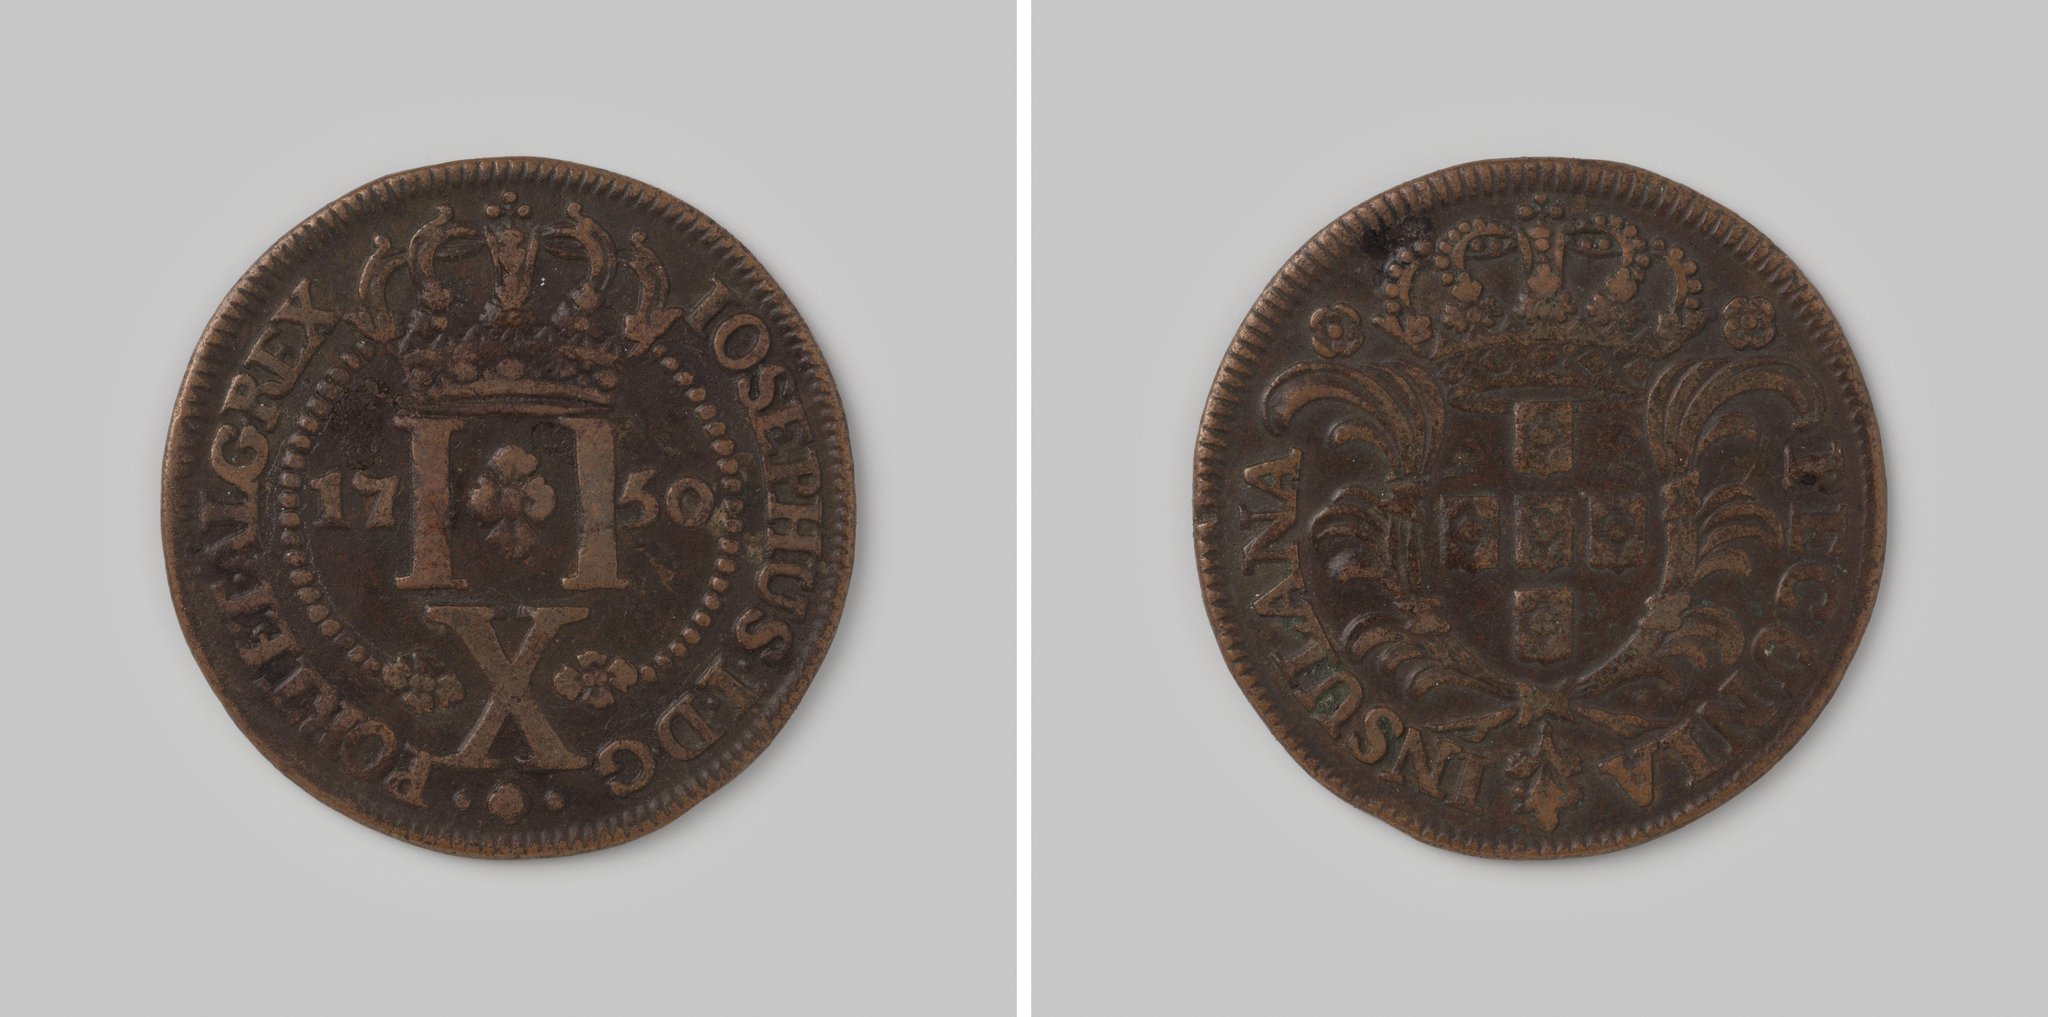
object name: coin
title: Azoren, koning José I van Portugal, 10 reis, 1750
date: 1750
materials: copper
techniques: striking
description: Koperen munt. Voorzijde: tussen jaartal twee letters I [=Josephus I]. Daarboven een kroon en daaronder waarde-aanduiding: X. Keerzijde: tussen twee samengebonden takken wapen van Portugal, waarboven kroon. Omschrift: percunia insulana [=munt van de eilanden]. Gladde rand.